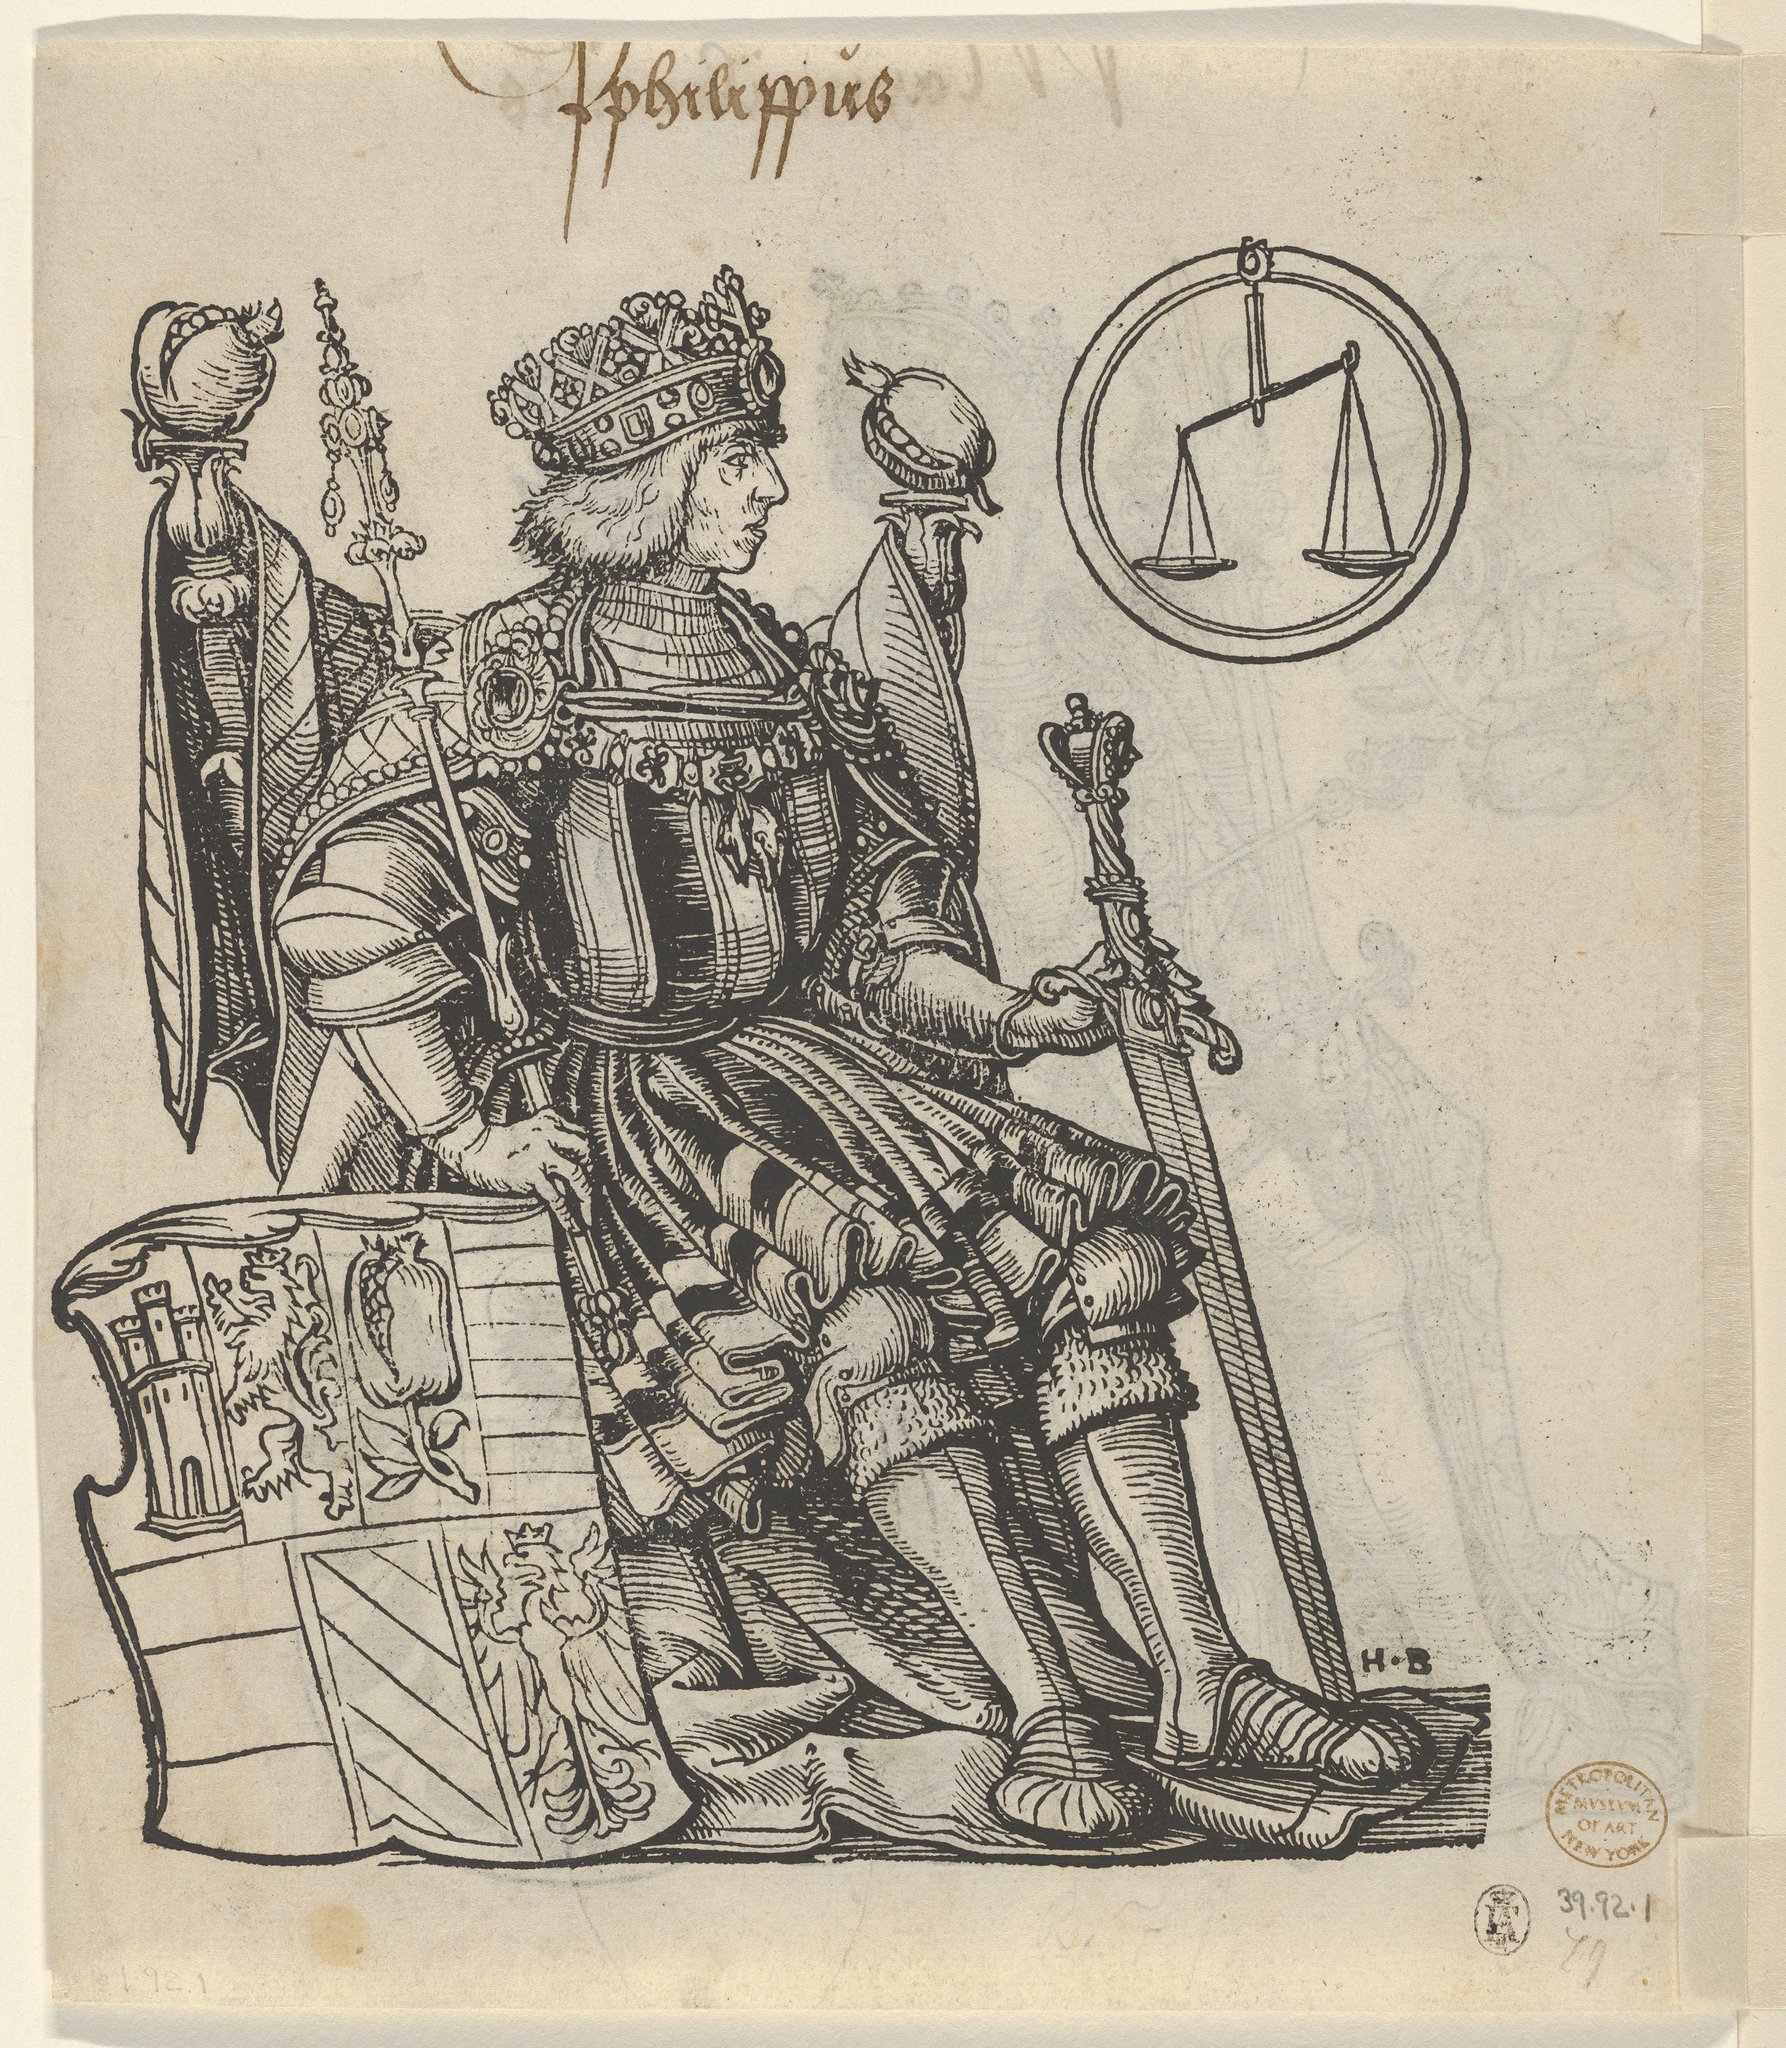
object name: print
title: Verso of a Sheet with Philip the Belle, from "The Genealogy of Emperor Maximilian I"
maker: hans burgkmair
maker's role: artist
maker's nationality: german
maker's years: 1473-1531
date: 1509-1512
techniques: woodcut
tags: swords,kings,coat of arms,scales